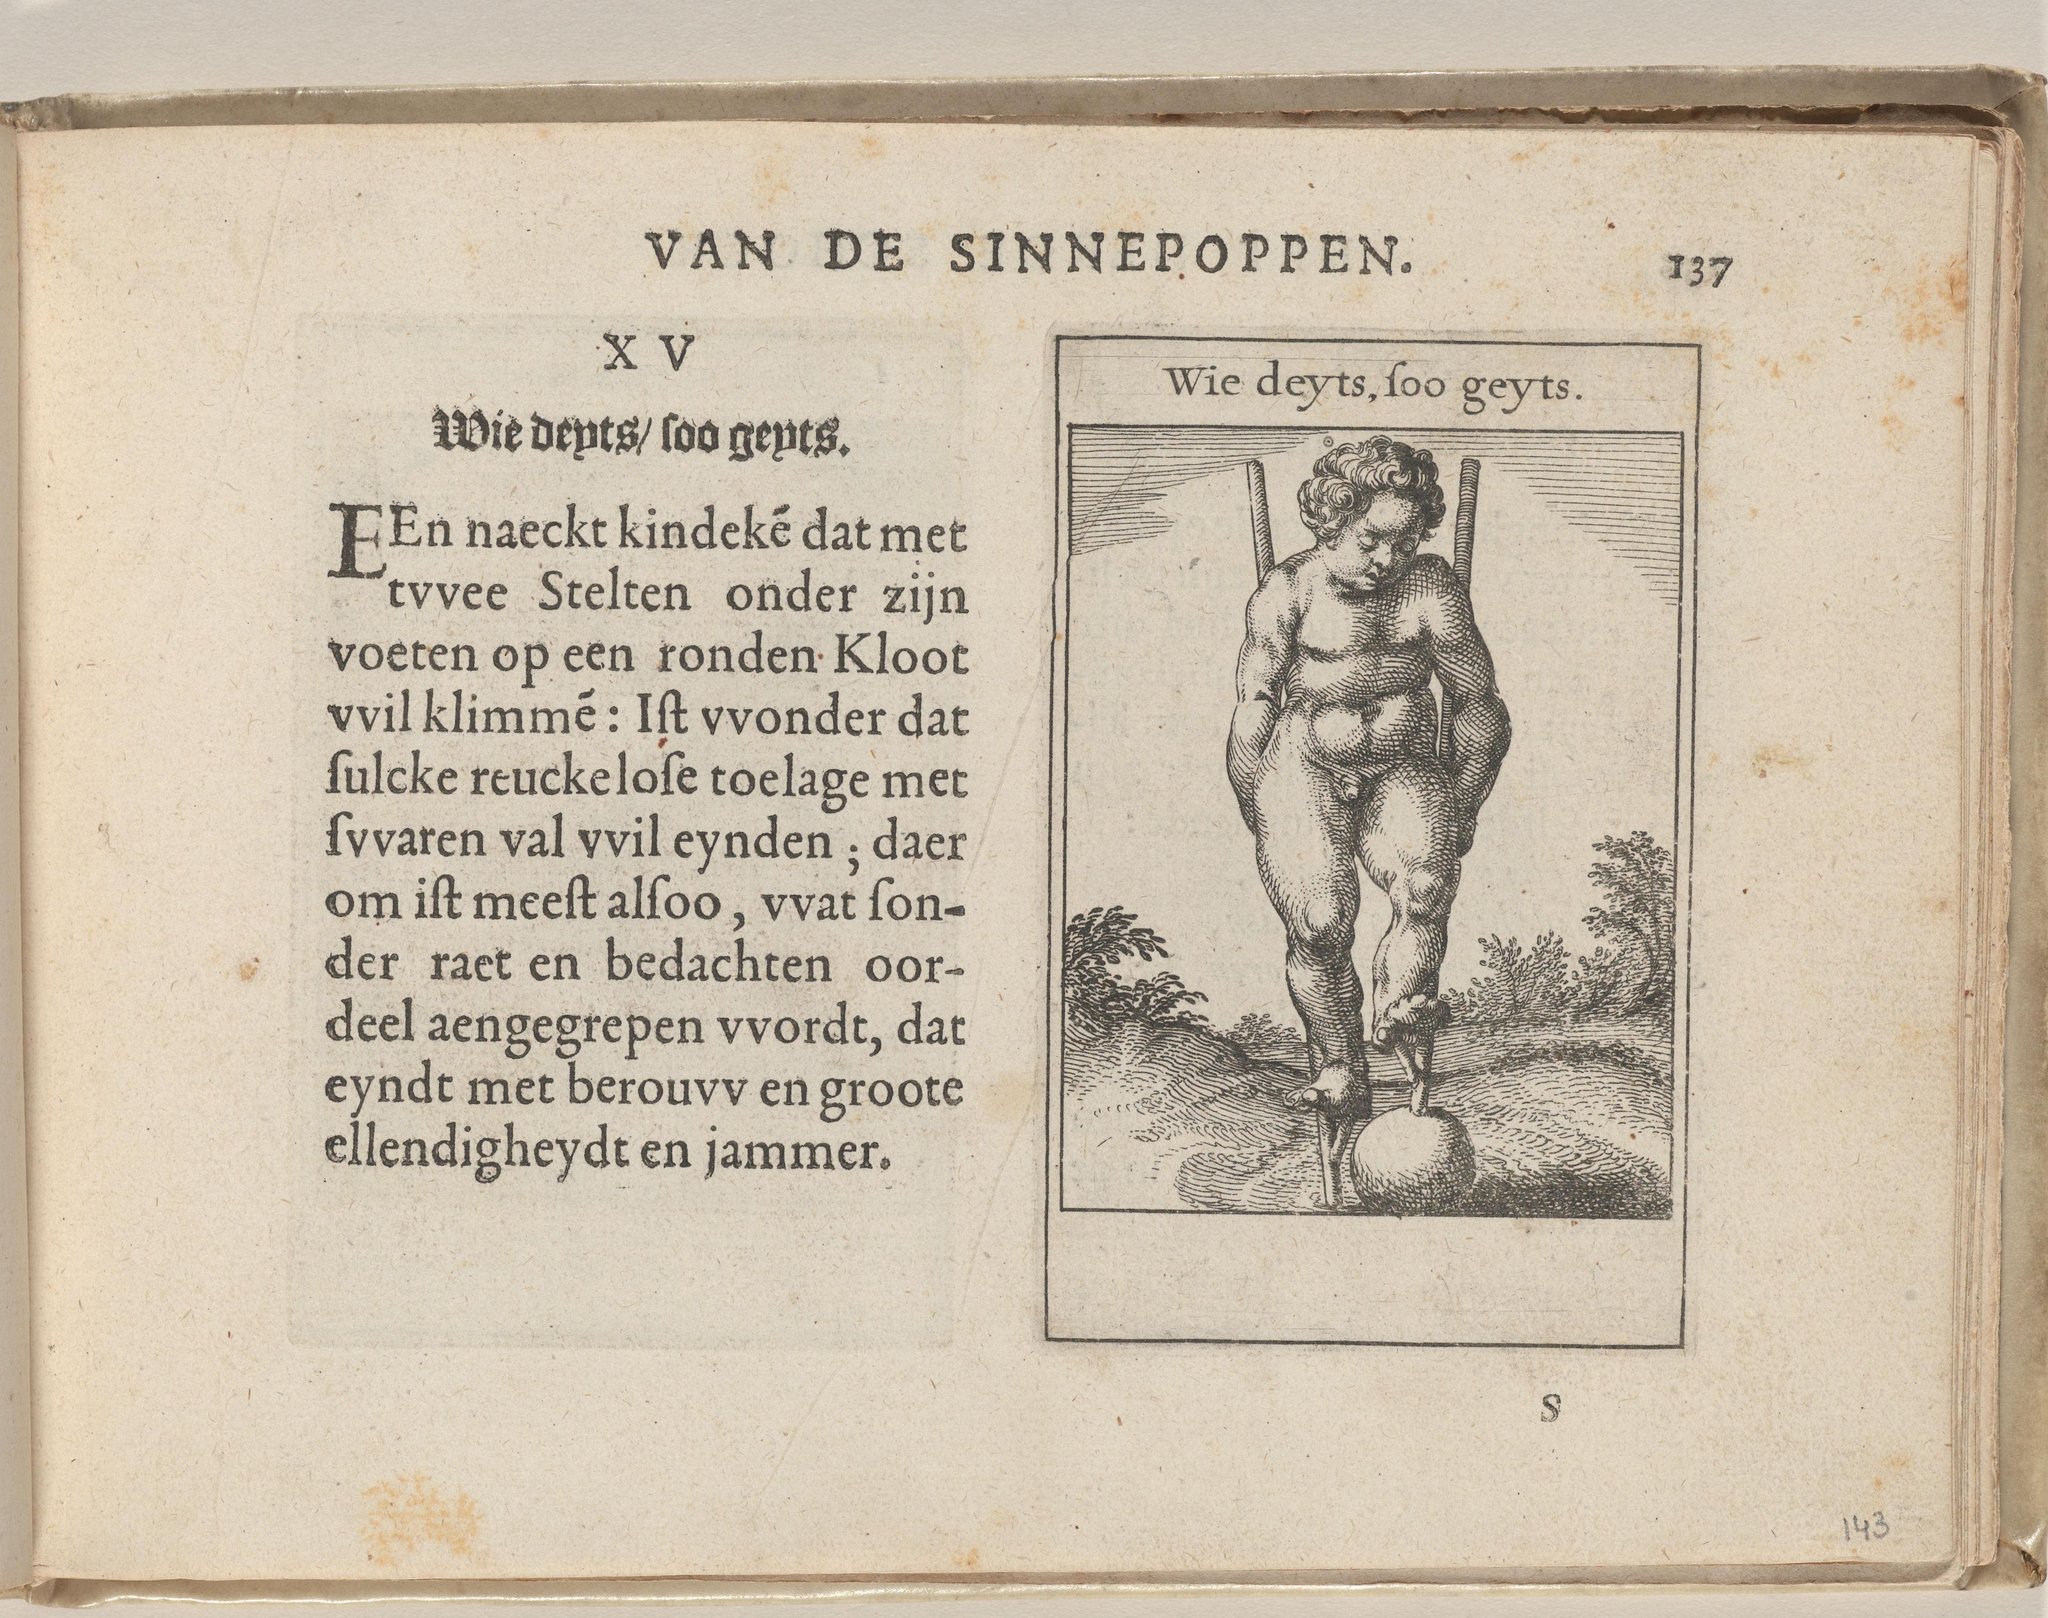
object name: album leaf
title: XV Wie deyts, soo geyts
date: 1614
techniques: engraving, printing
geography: amsterdam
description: XV Wie deyts, soo geyts. Derde schok. Onderdeel van 'Sinnepoppen', R. Visscher, 1614.